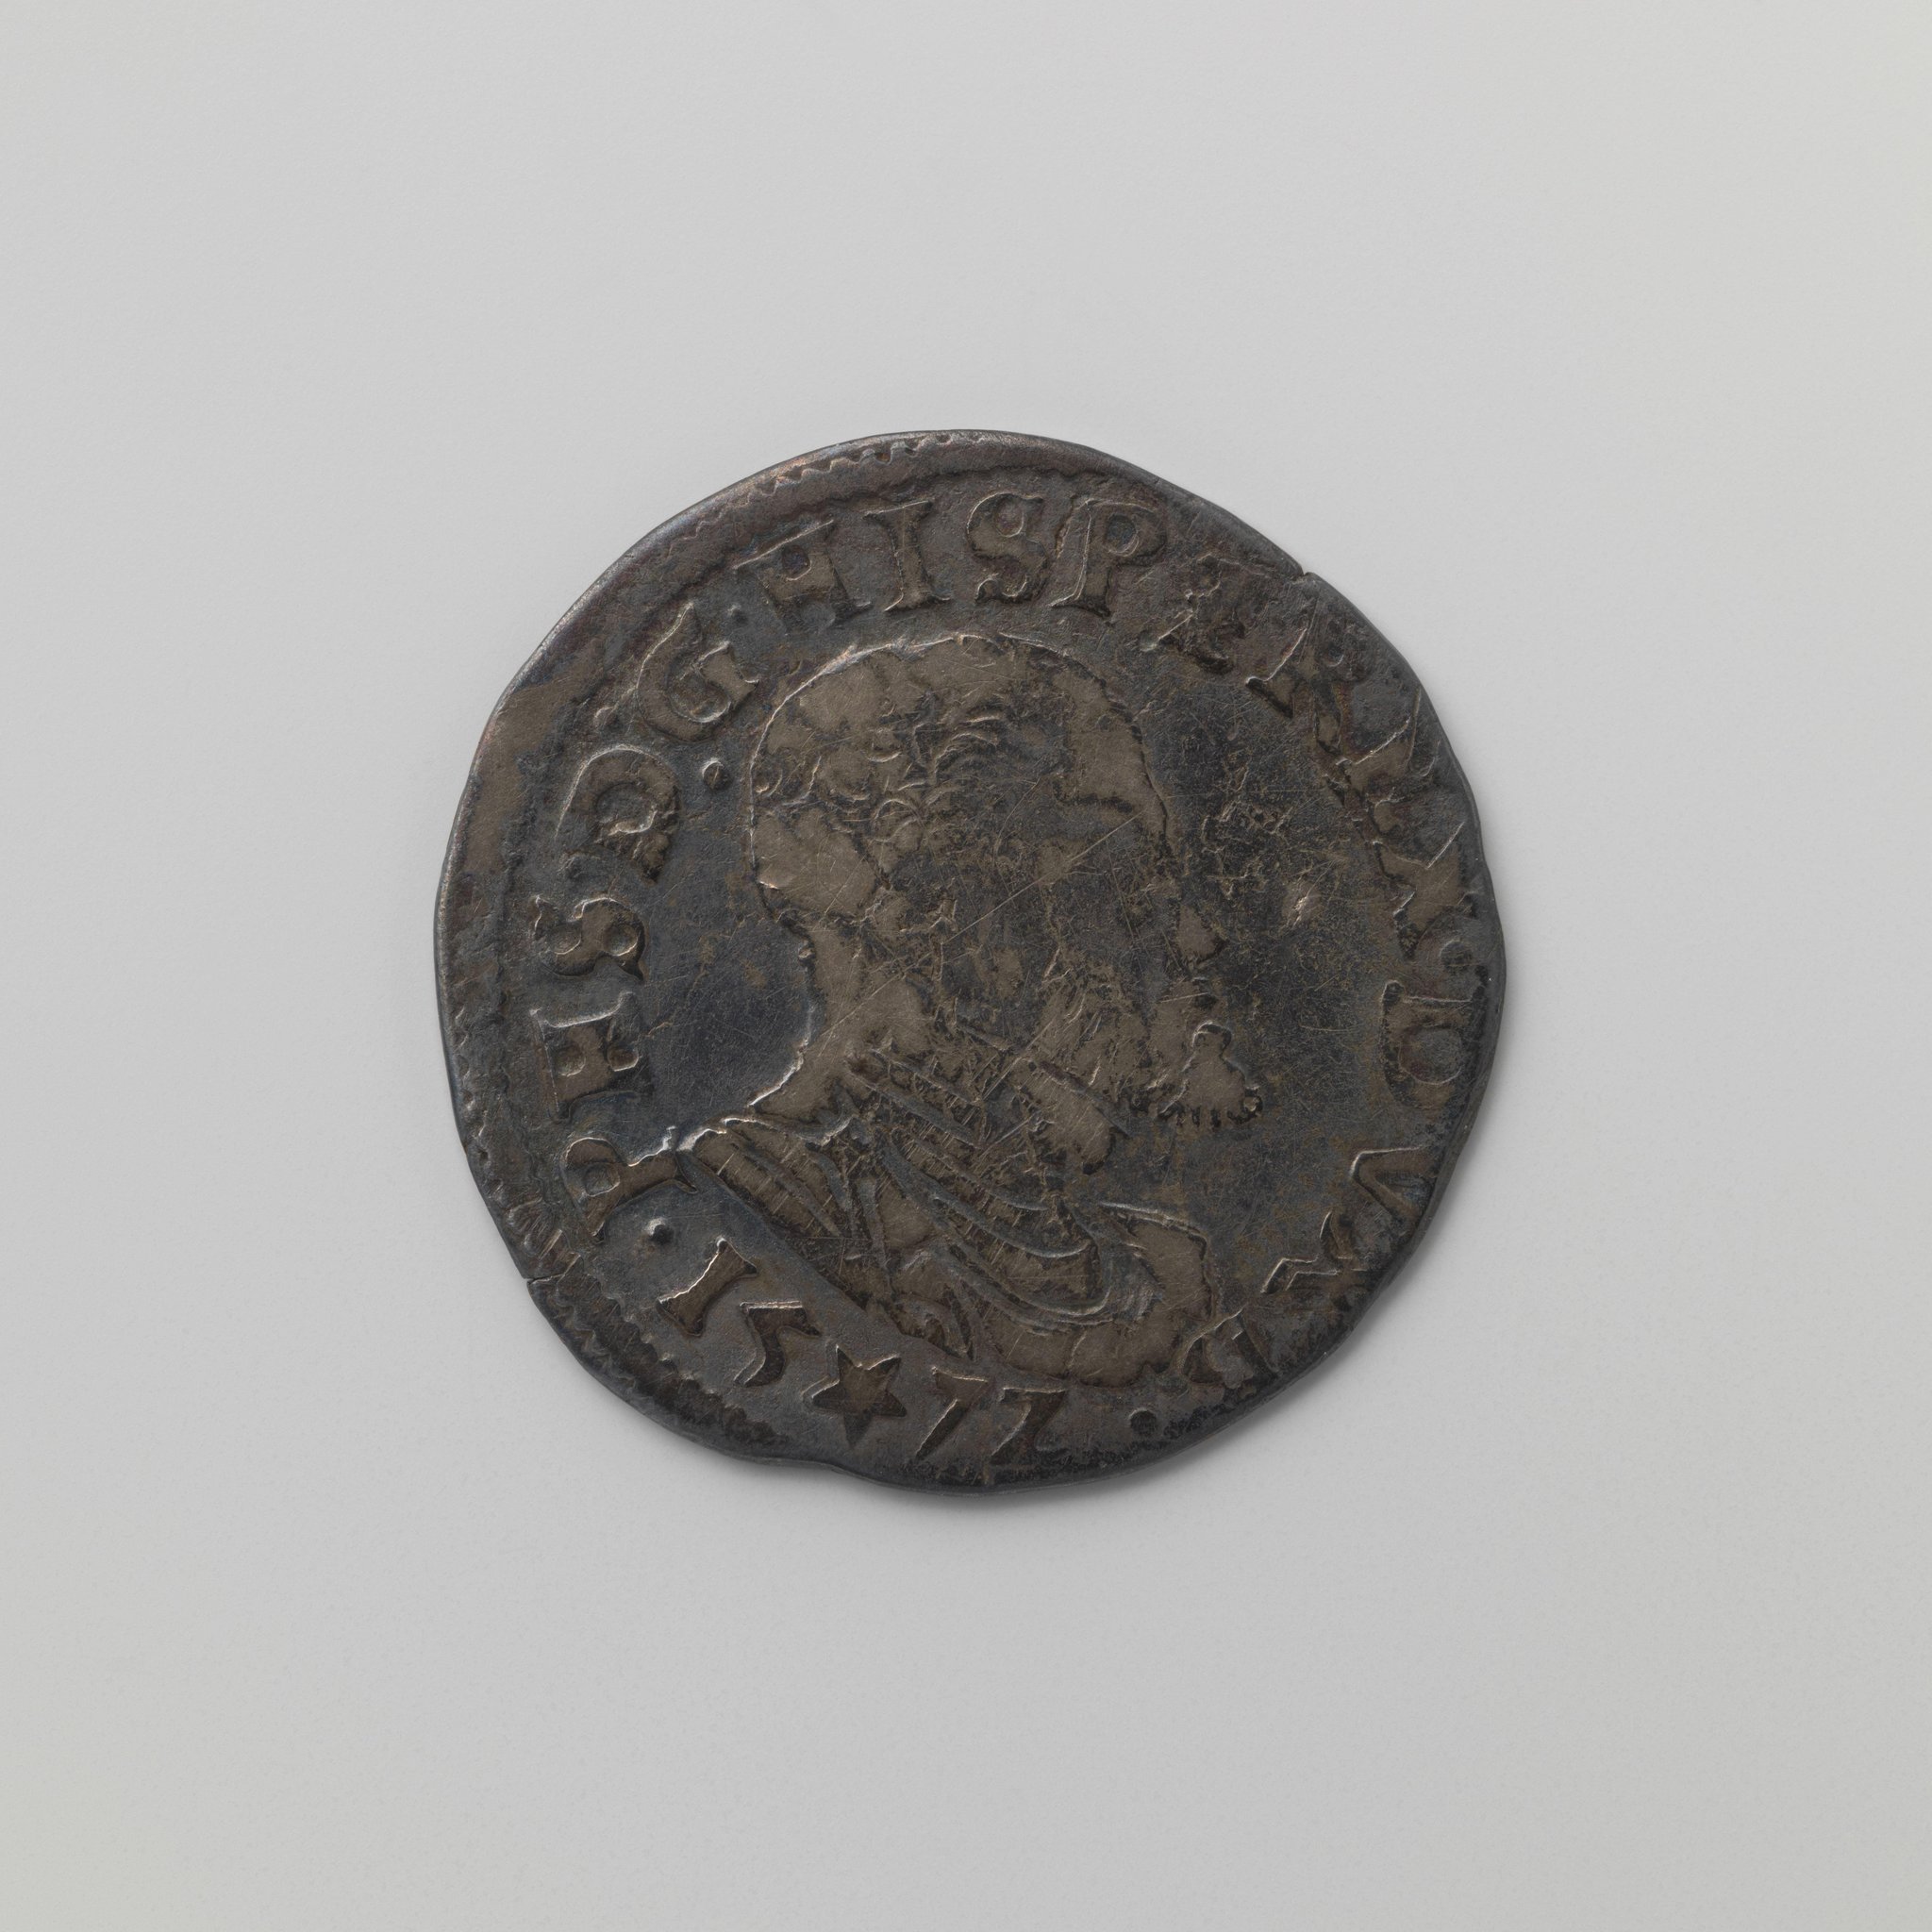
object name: coin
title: Brabant, Philips II, tiende philipsdaalder, 1577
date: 1577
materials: silver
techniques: striking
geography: maastricht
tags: philip ii of spain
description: Zilveren munt. Voorzijde: hoofd van Philips II naar rechts. Jaartal, waartussen ster, in omschrift.Keerzijde: op stokkenkruis vuurijzer met vonken. Daarboven kroon, daaronder gulden vlies.